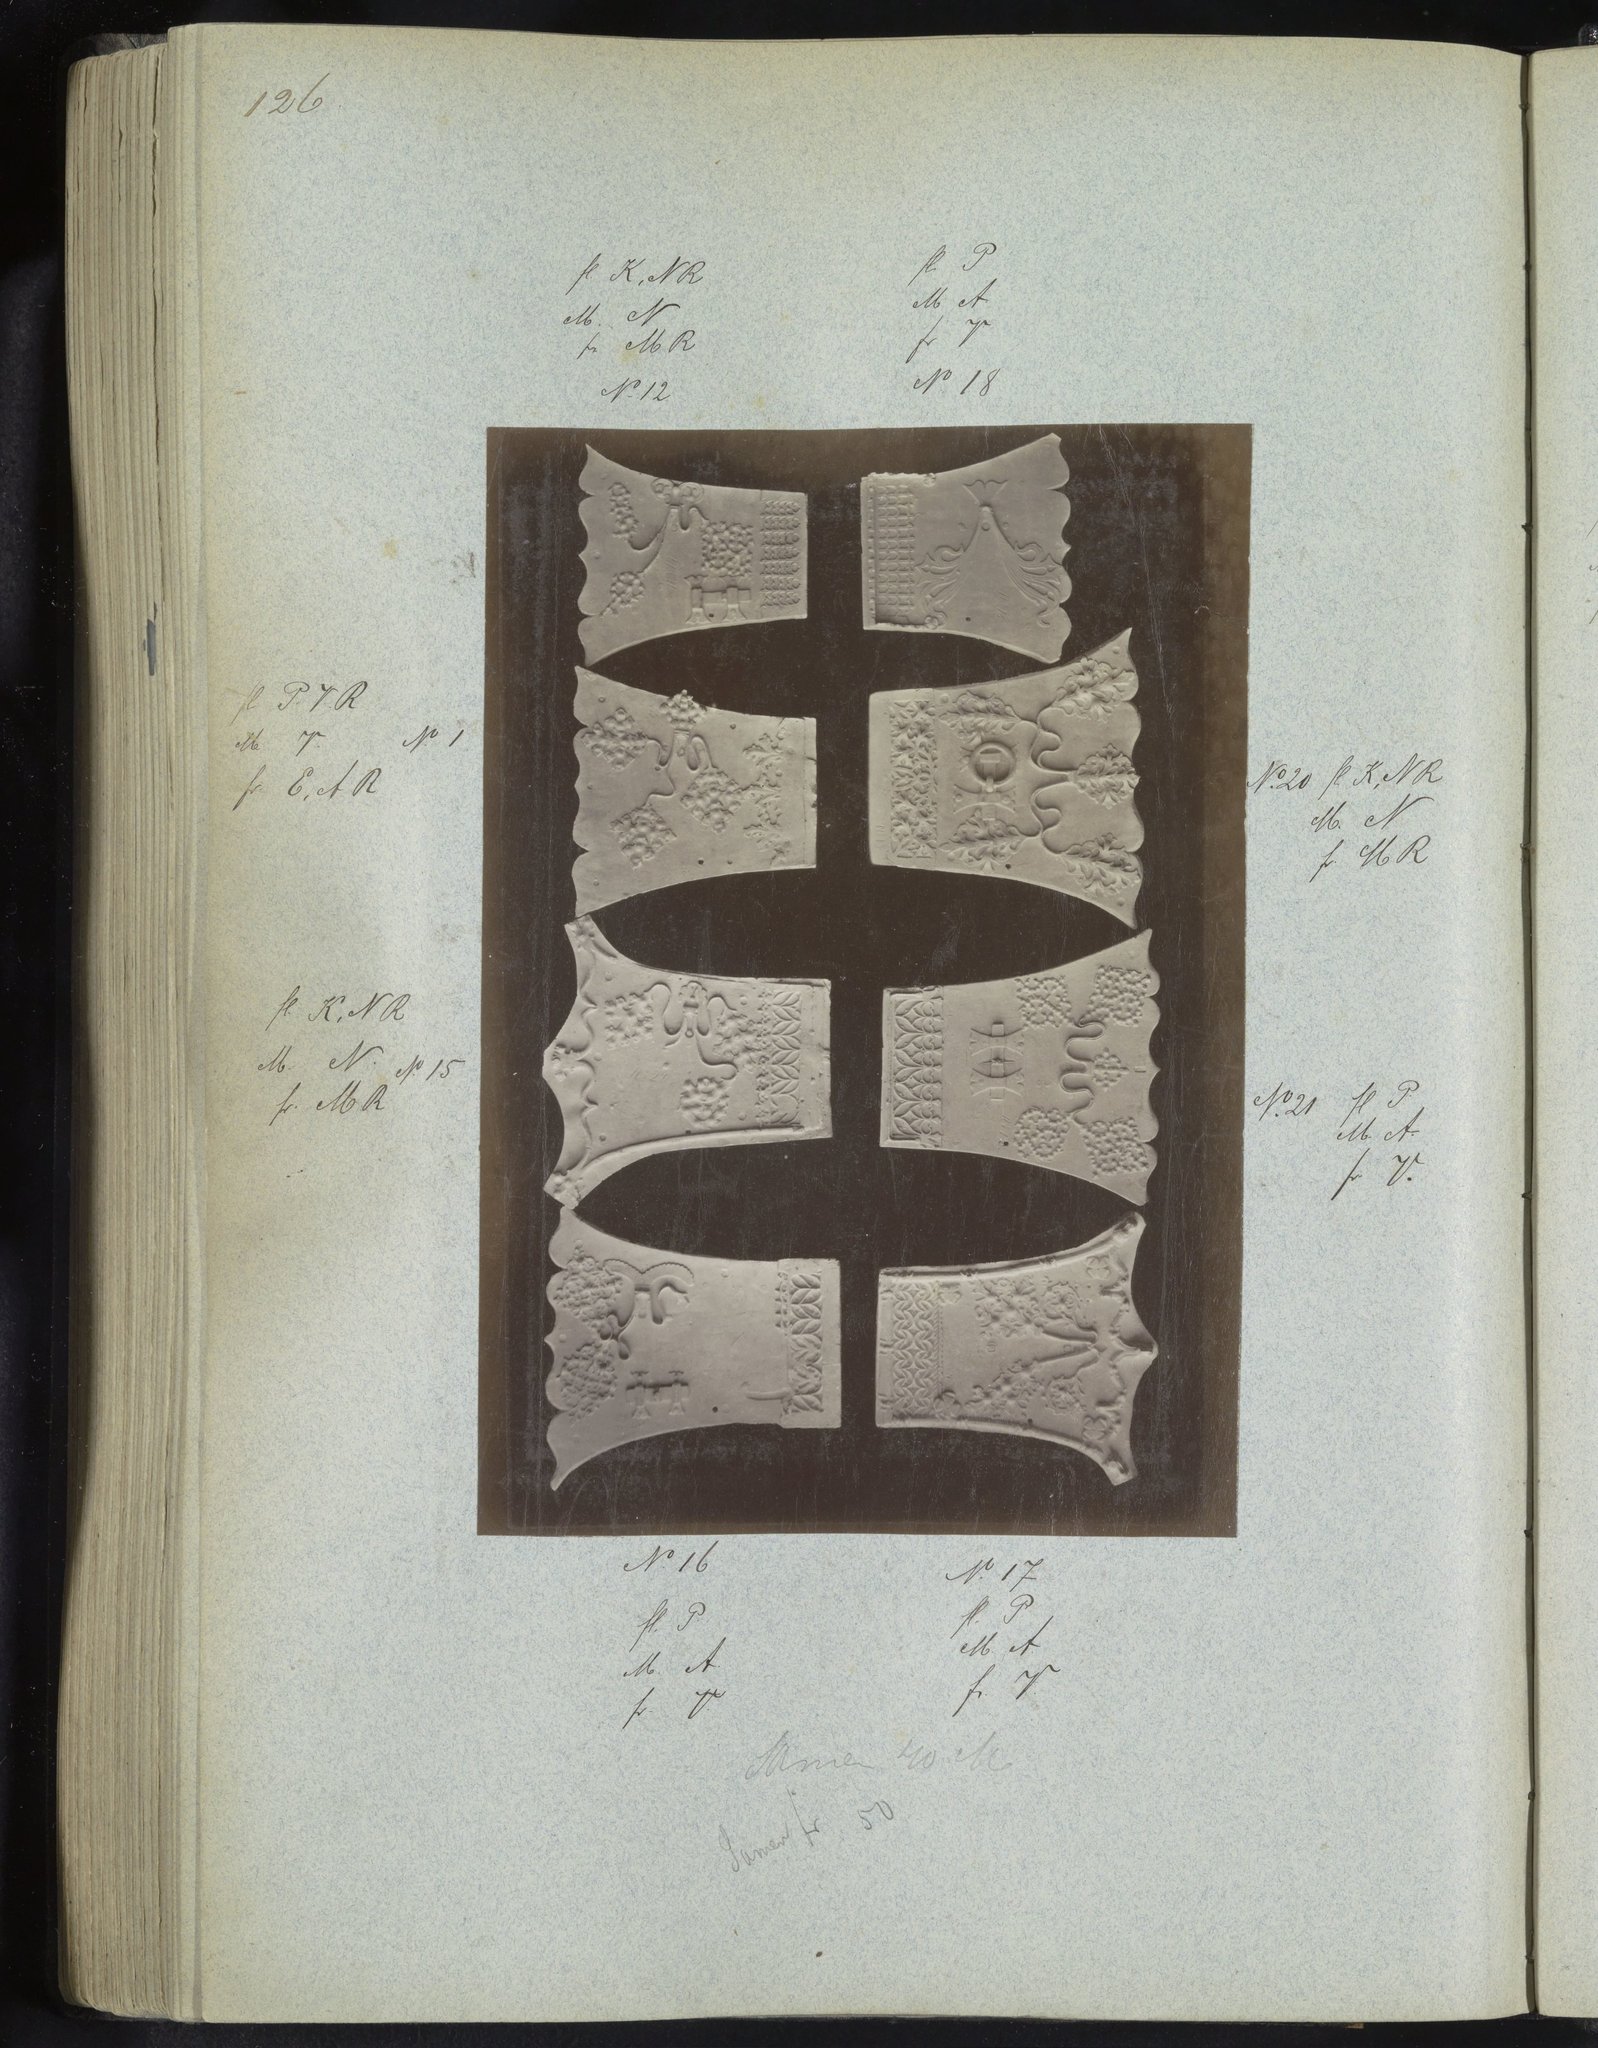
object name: photograph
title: Acht gipsen afgietsels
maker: Anonymous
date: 1875-1900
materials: paper, photographic support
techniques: albumen print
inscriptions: annotation